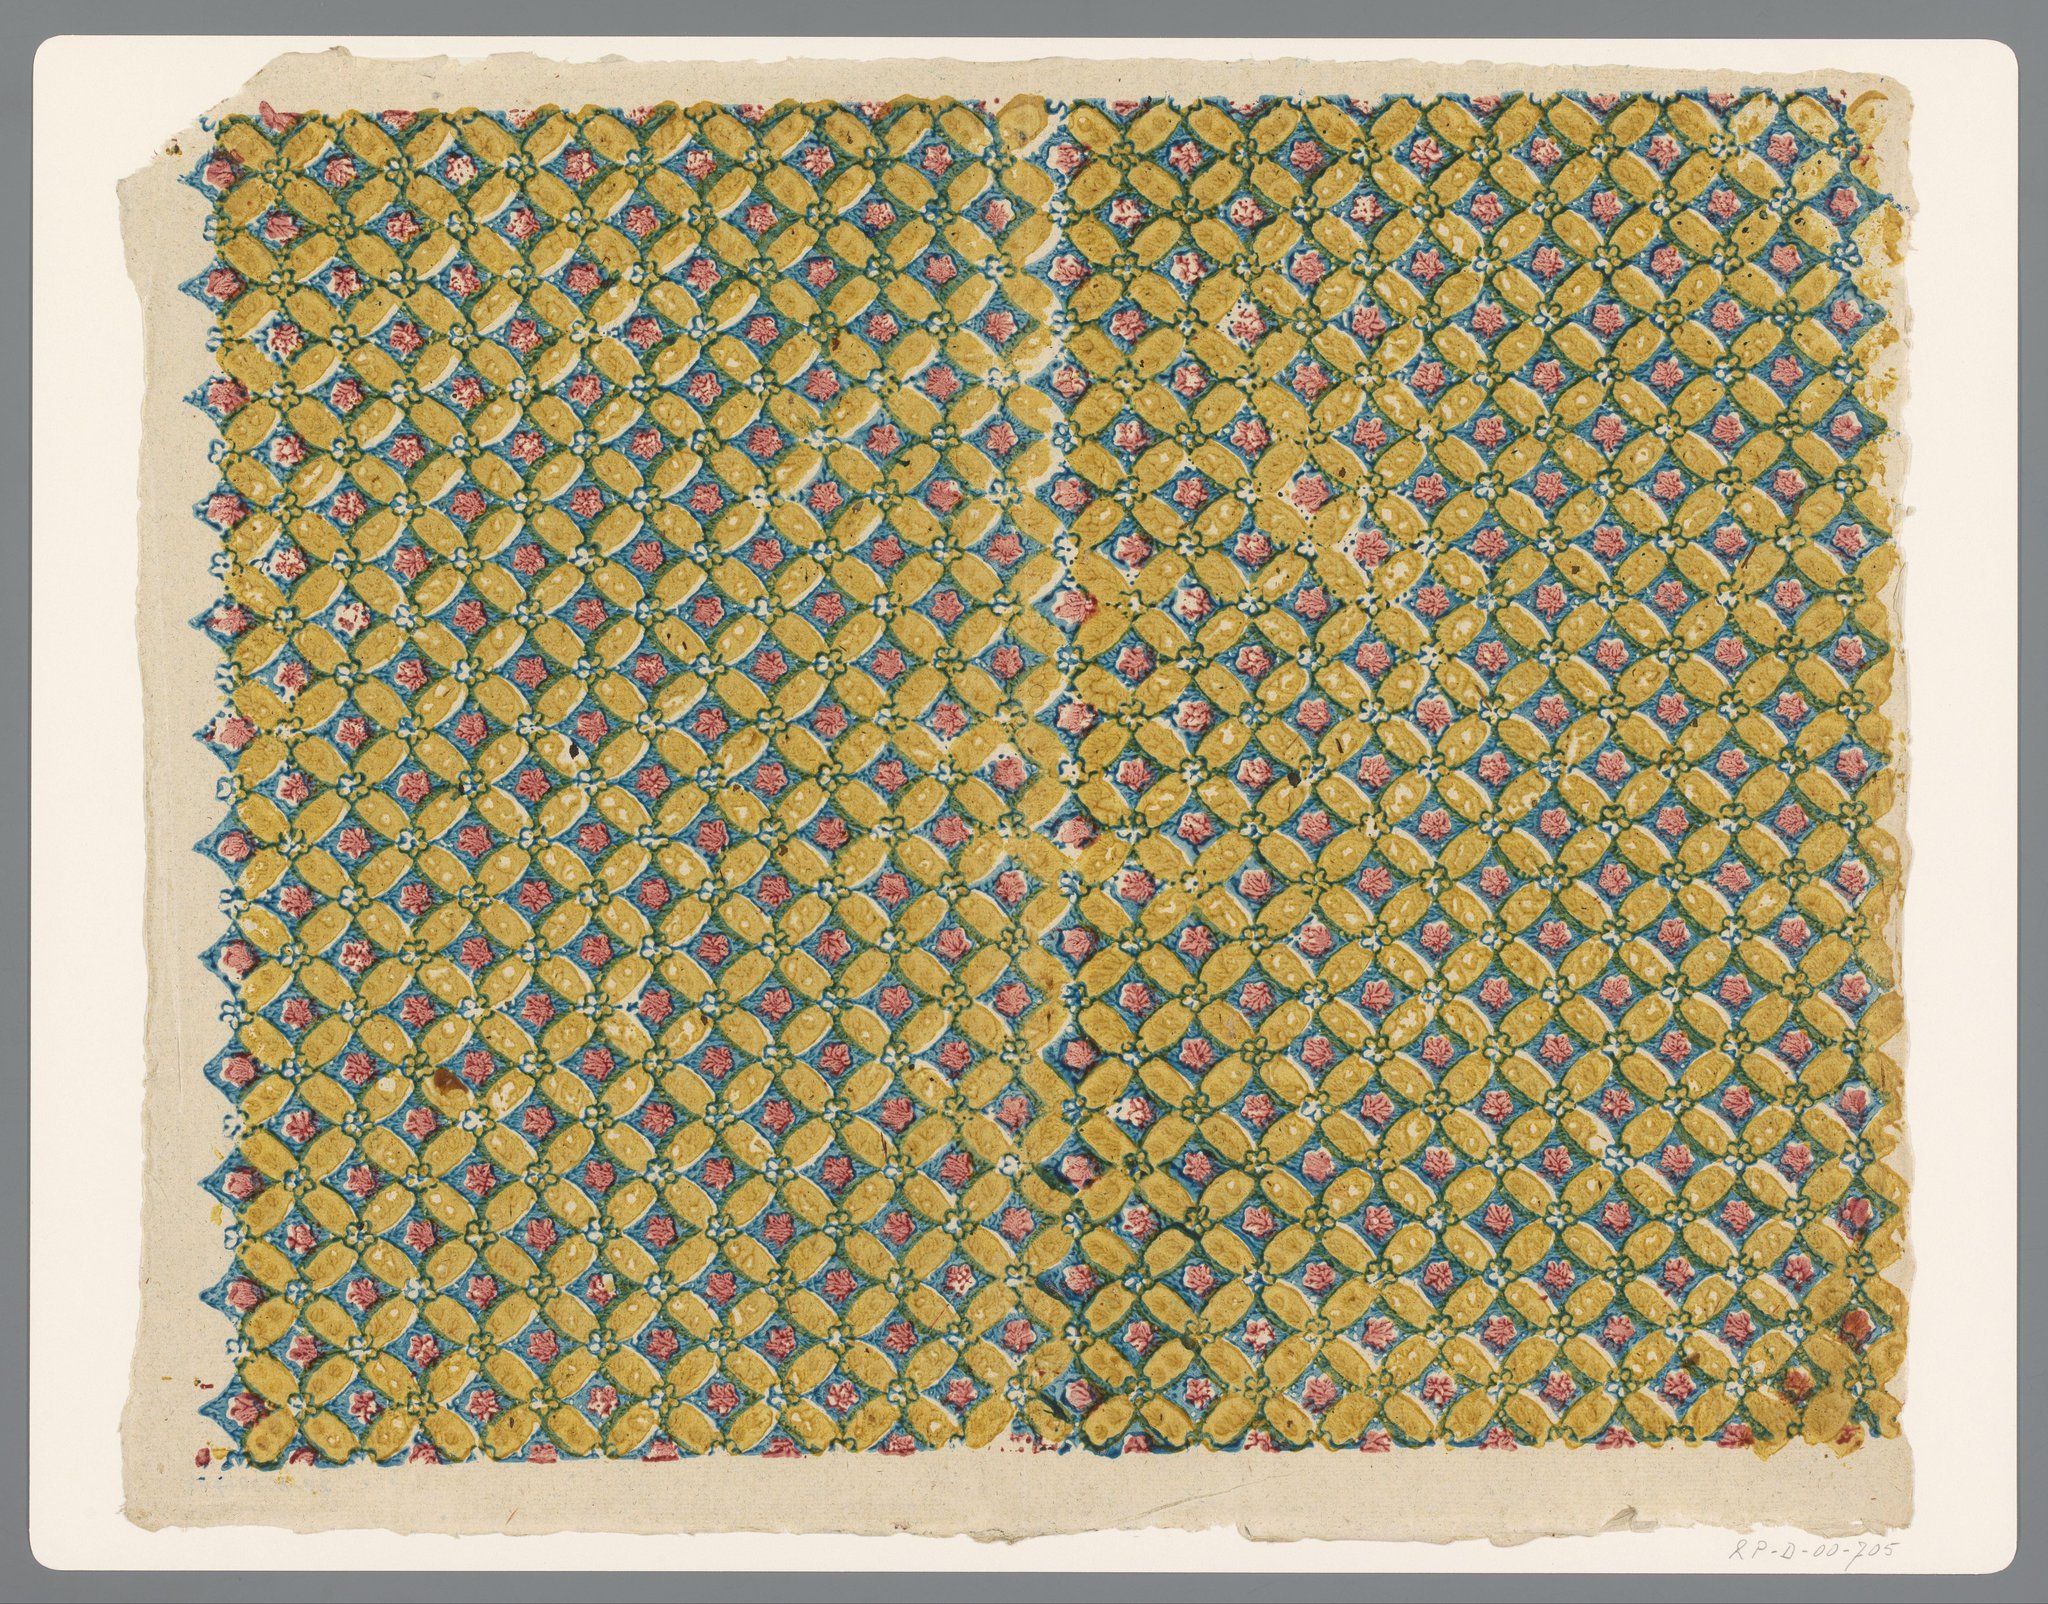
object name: printed paper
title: Blad met ruitenpatroon van bloemmotief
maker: Anonymous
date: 1750-1900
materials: lacquer, paper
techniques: printing block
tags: ornament derived from plant forms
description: Blad met ruitenpatroon van bloemmotief en overhoekse rozetten.